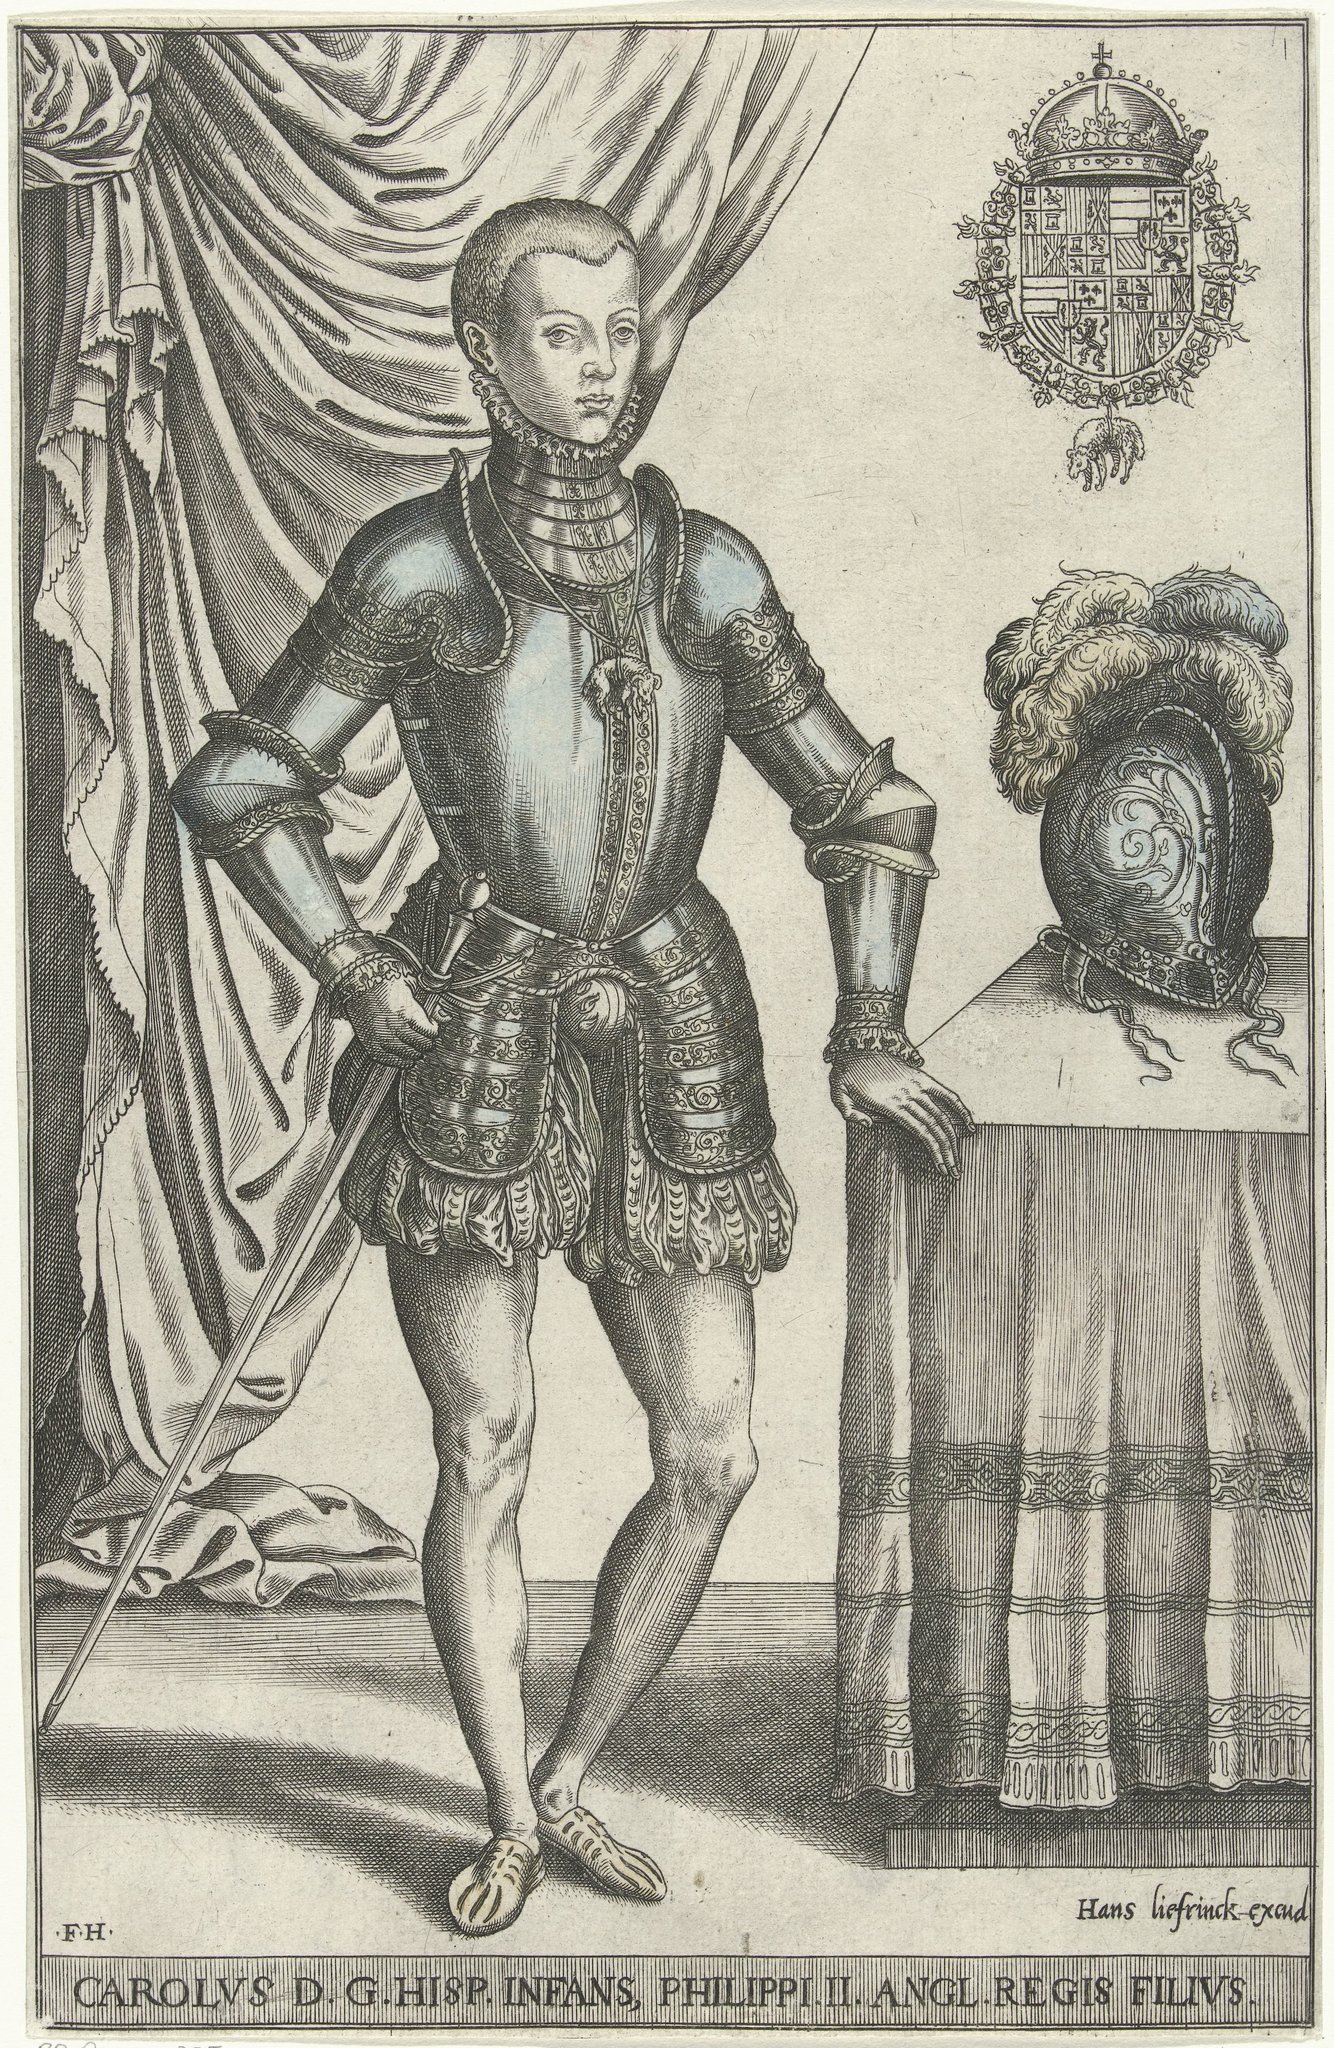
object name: print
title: Portretten van koningen en koninginnen ten voeten uit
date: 1546-1562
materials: paper, watercolor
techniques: brush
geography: antwerp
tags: madrid, prins, carlos van spanje (prins)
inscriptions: collector's mark: Lugt 2760, collector's mark: Lugt 151, collector's mark: Lugt 2228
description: Portret van Don Carlos, infante van Spanje, ten voeten uit naar rechts, gekleed in een harnas. Hij staat naast een tafel met daarop een helm. Rechtsboven zijn wapenschild. Een regel tekst in het Latijn middenonder.